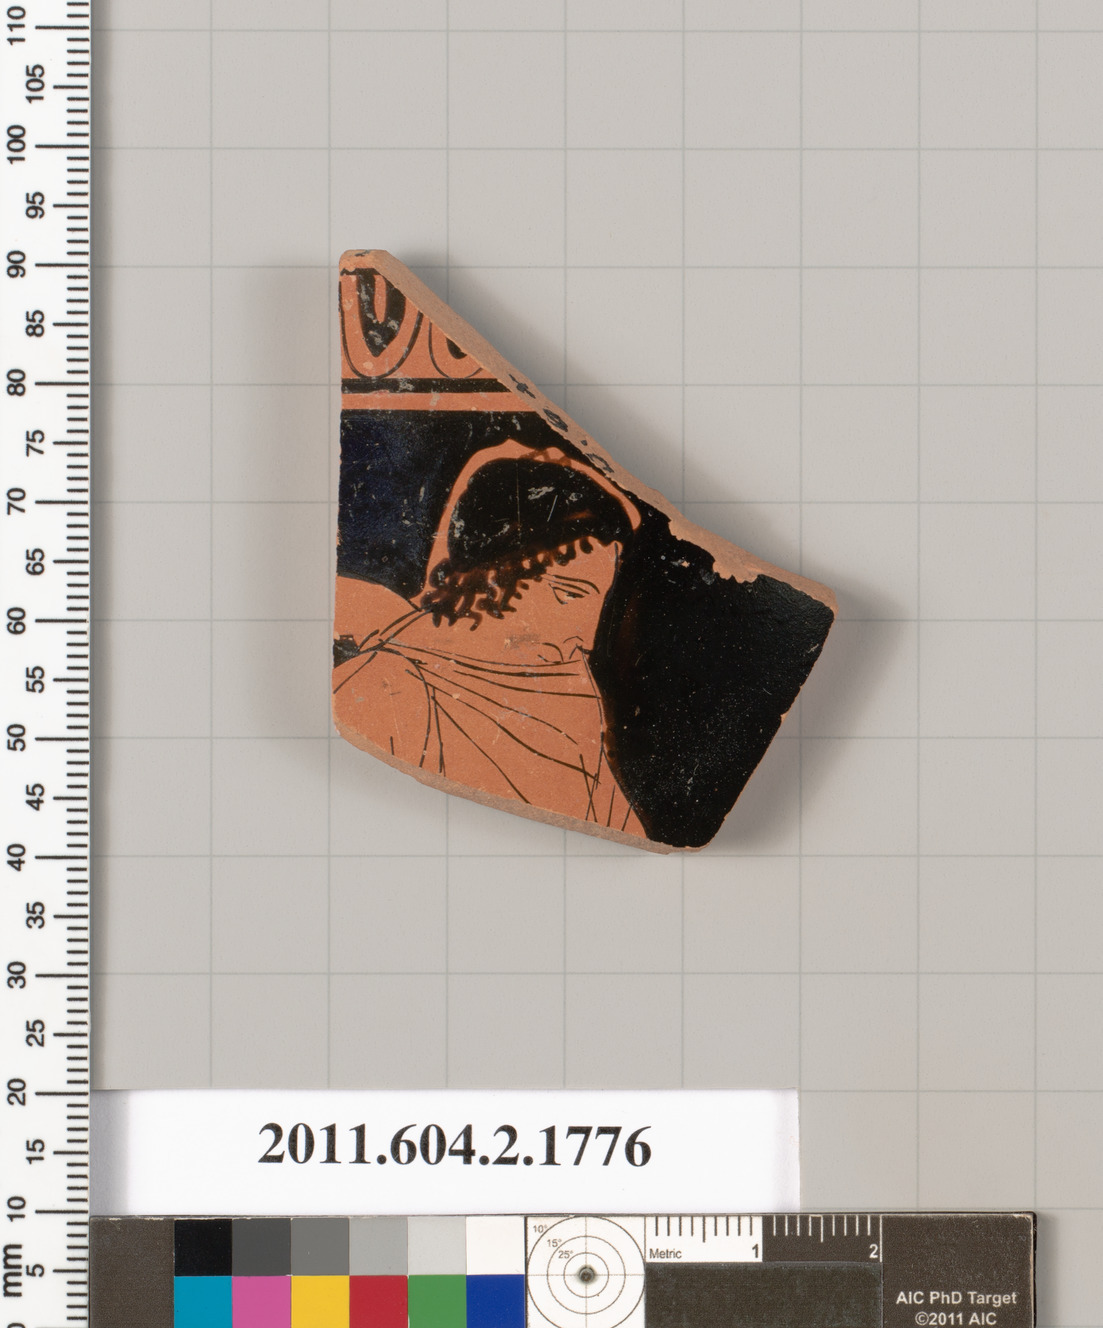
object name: skyphos fragment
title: Terracotta rim fragment of a skyphos (deep drinking cup)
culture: greek, attic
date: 450-426 BCE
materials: terracotta